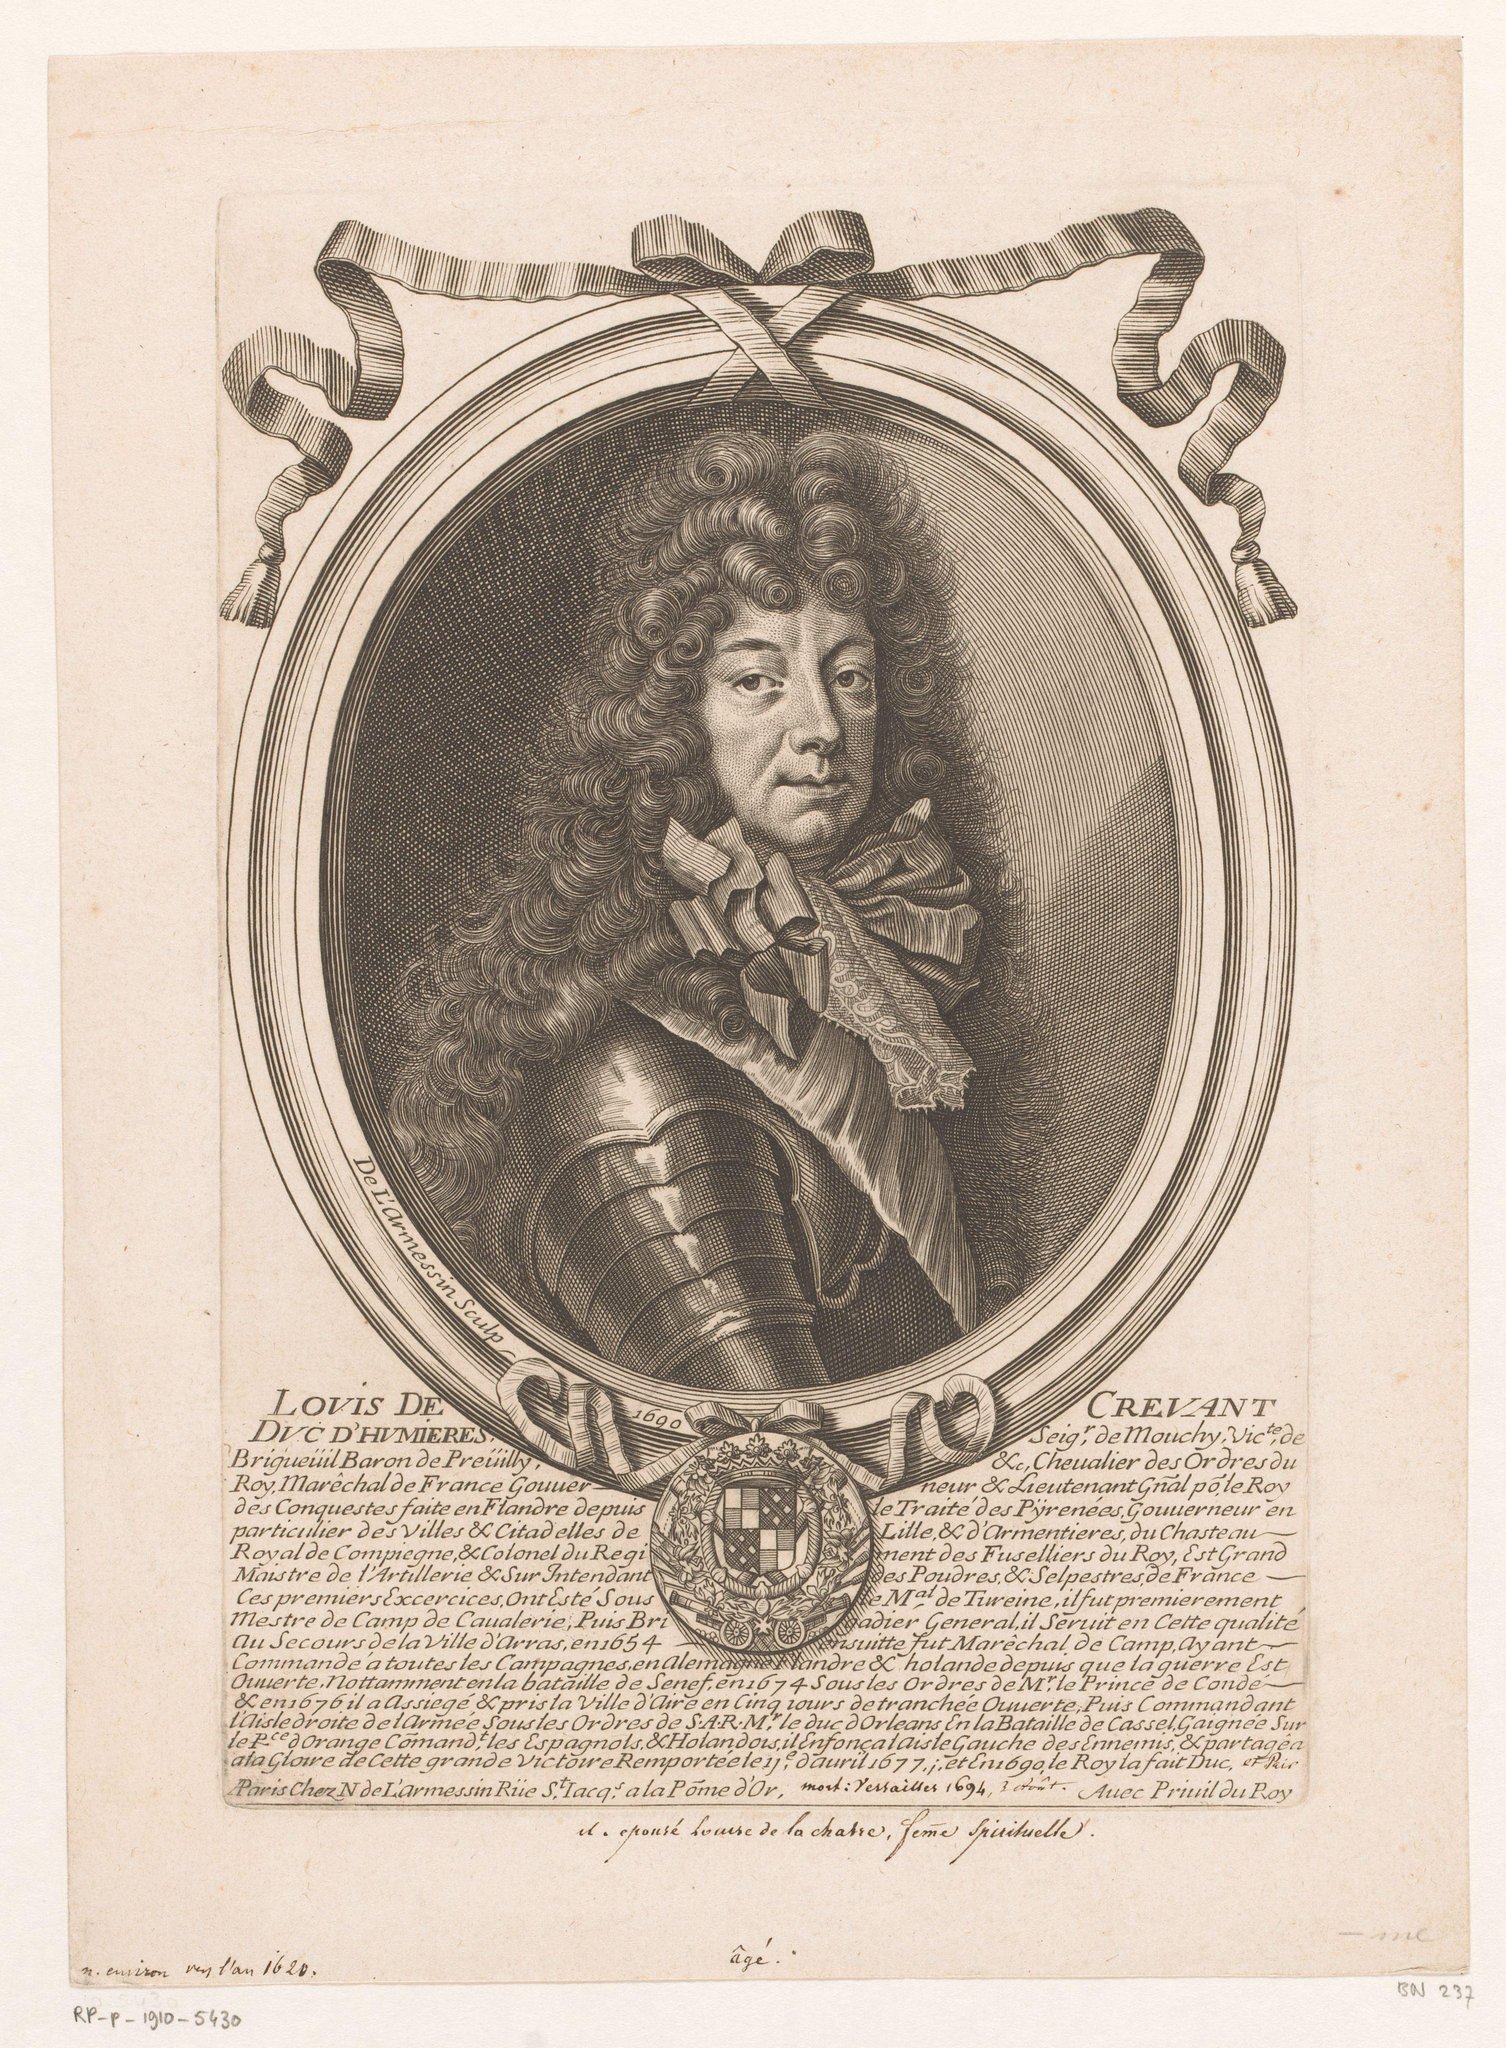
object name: print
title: Portret van Louis de Crévant, hertog van Humières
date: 1690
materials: paper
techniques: engraving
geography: france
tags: louis de crévant (hertog van humières), commander-in-chief, general, marshal, historical persons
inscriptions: collector's mark: Lugt 2228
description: Maakt deel uit van een grootschalige serie met portretten van prominente figuren. Binnen de serie bevindt zich een sectie getiteld 'Les Augustes Représentations De tous les Roys De France depuis Pharamond Iusqu'à Louys XIIII'. De serie werd respectievelijk uitgegeven door Pierre Bertrand, door zijn weduwe en door De Larmessin zelf.